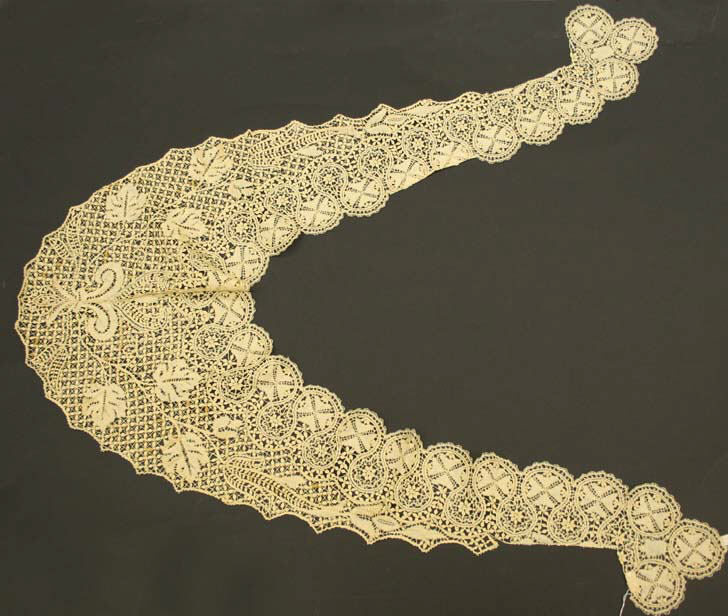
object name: collar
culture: maltese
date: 1801-1900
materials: silk